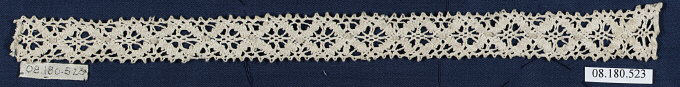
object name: insertion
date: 1501-1600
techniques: lace